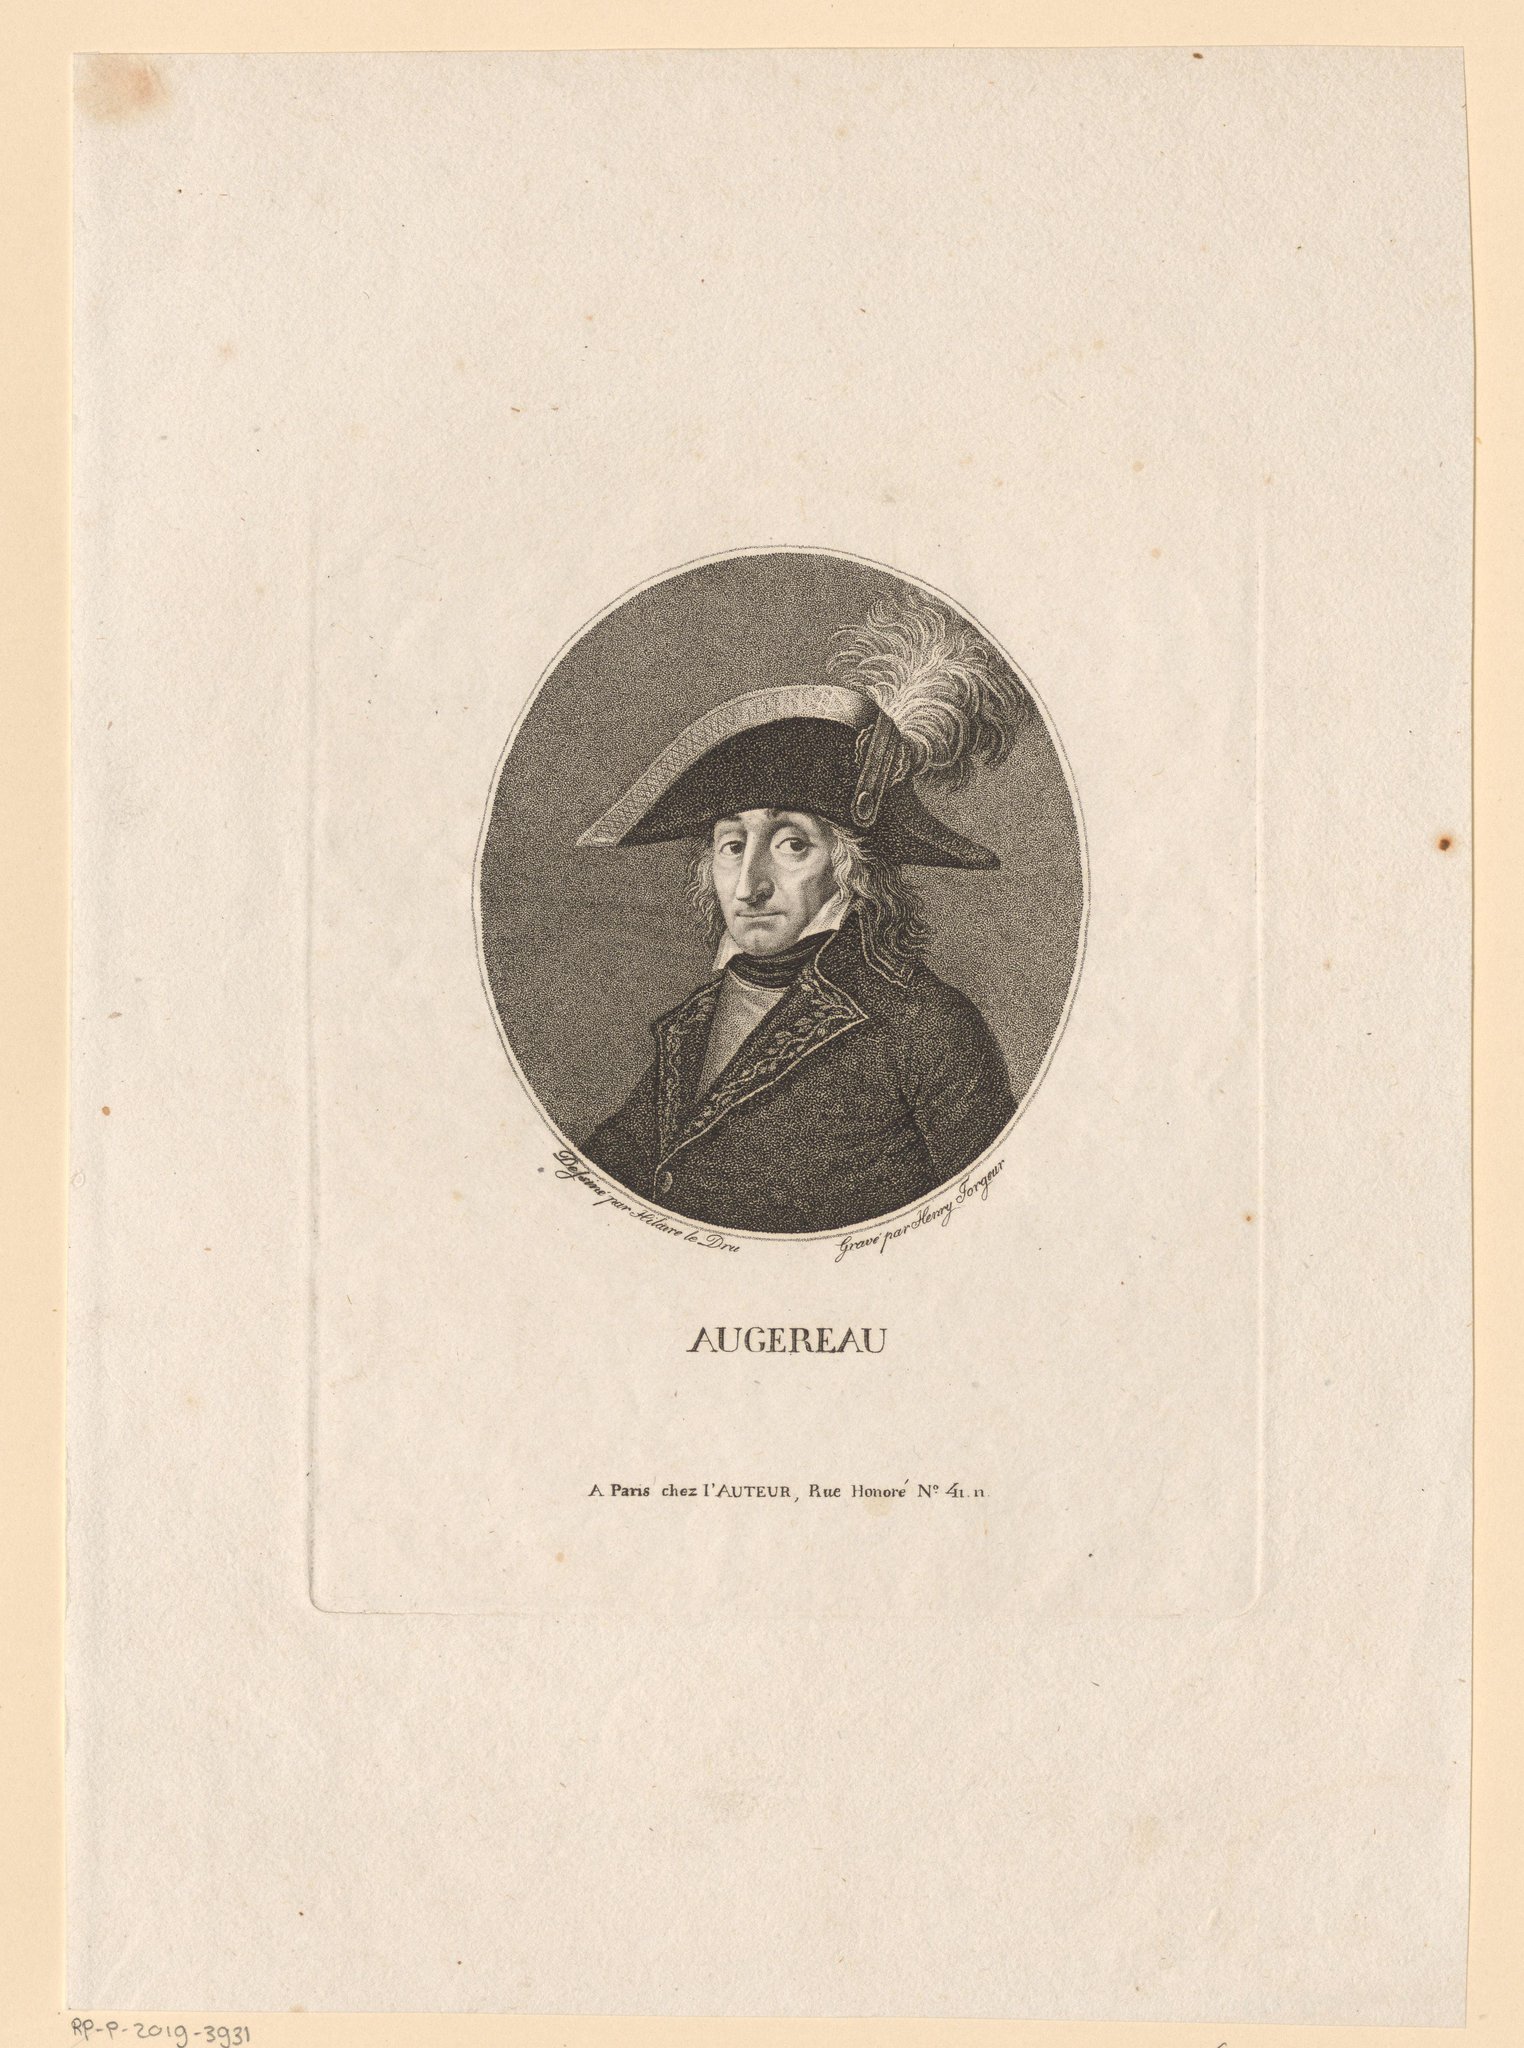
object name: print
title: Portret van Pierre François Charles Augerau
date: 1790-1820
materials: paper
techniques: etching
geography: paris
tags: paris, politician, historical persons